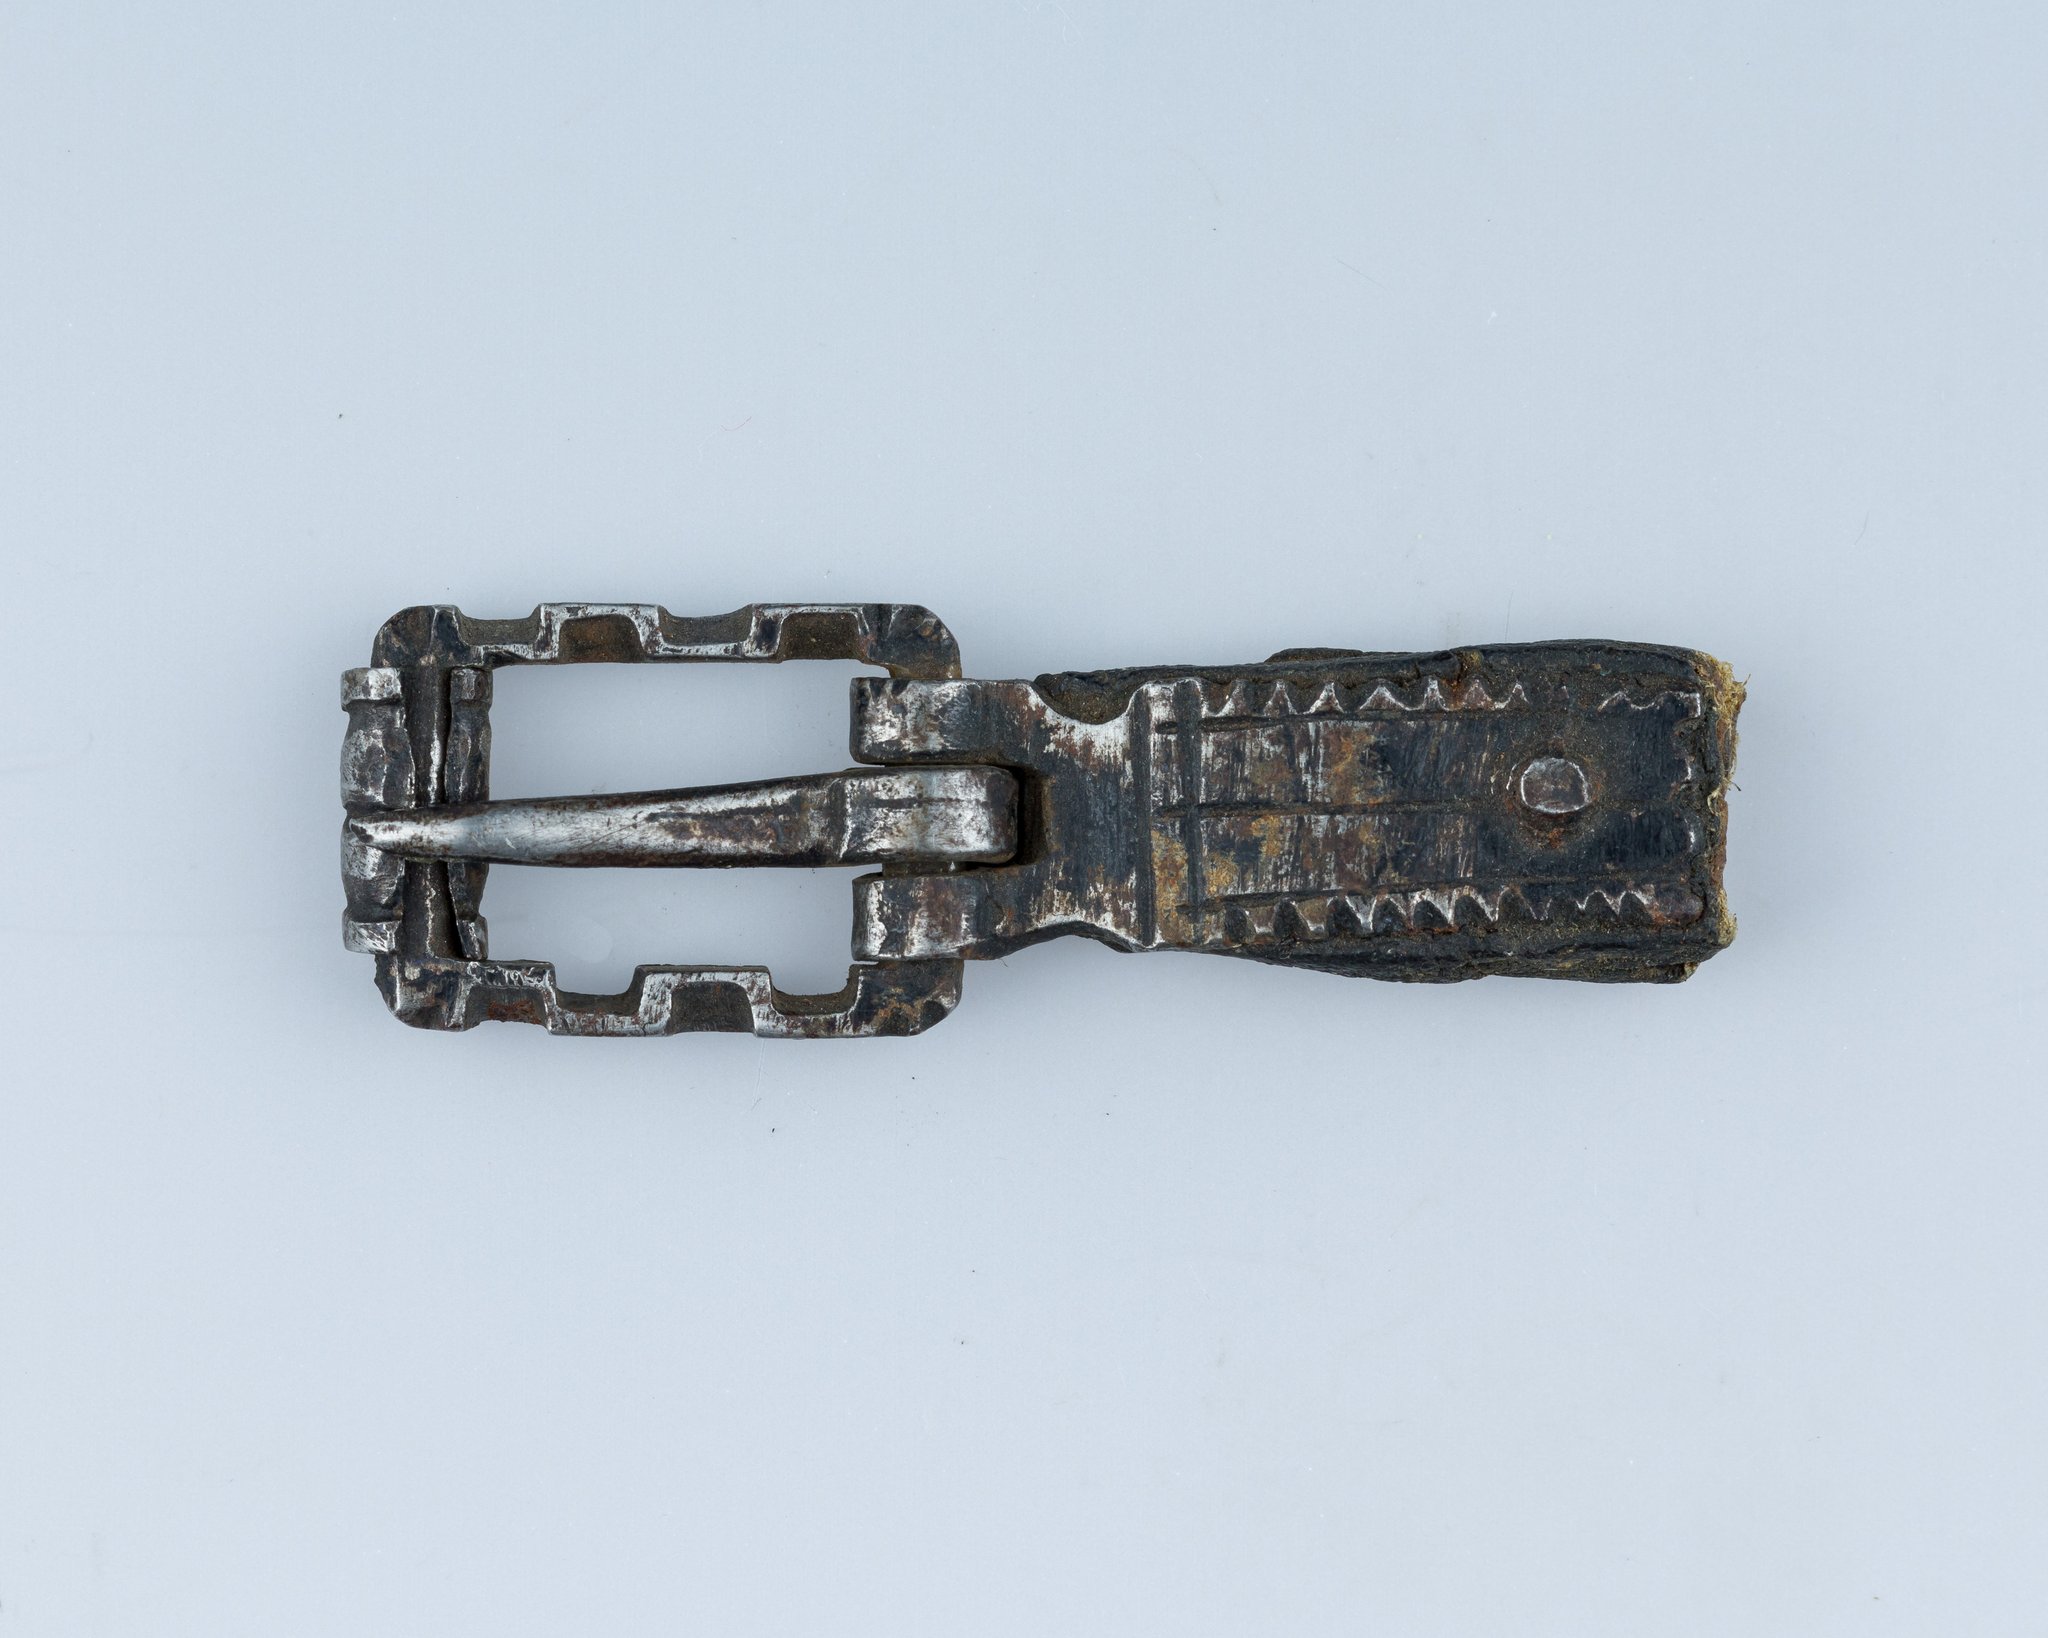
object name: buckle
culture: german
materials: steel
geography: germany